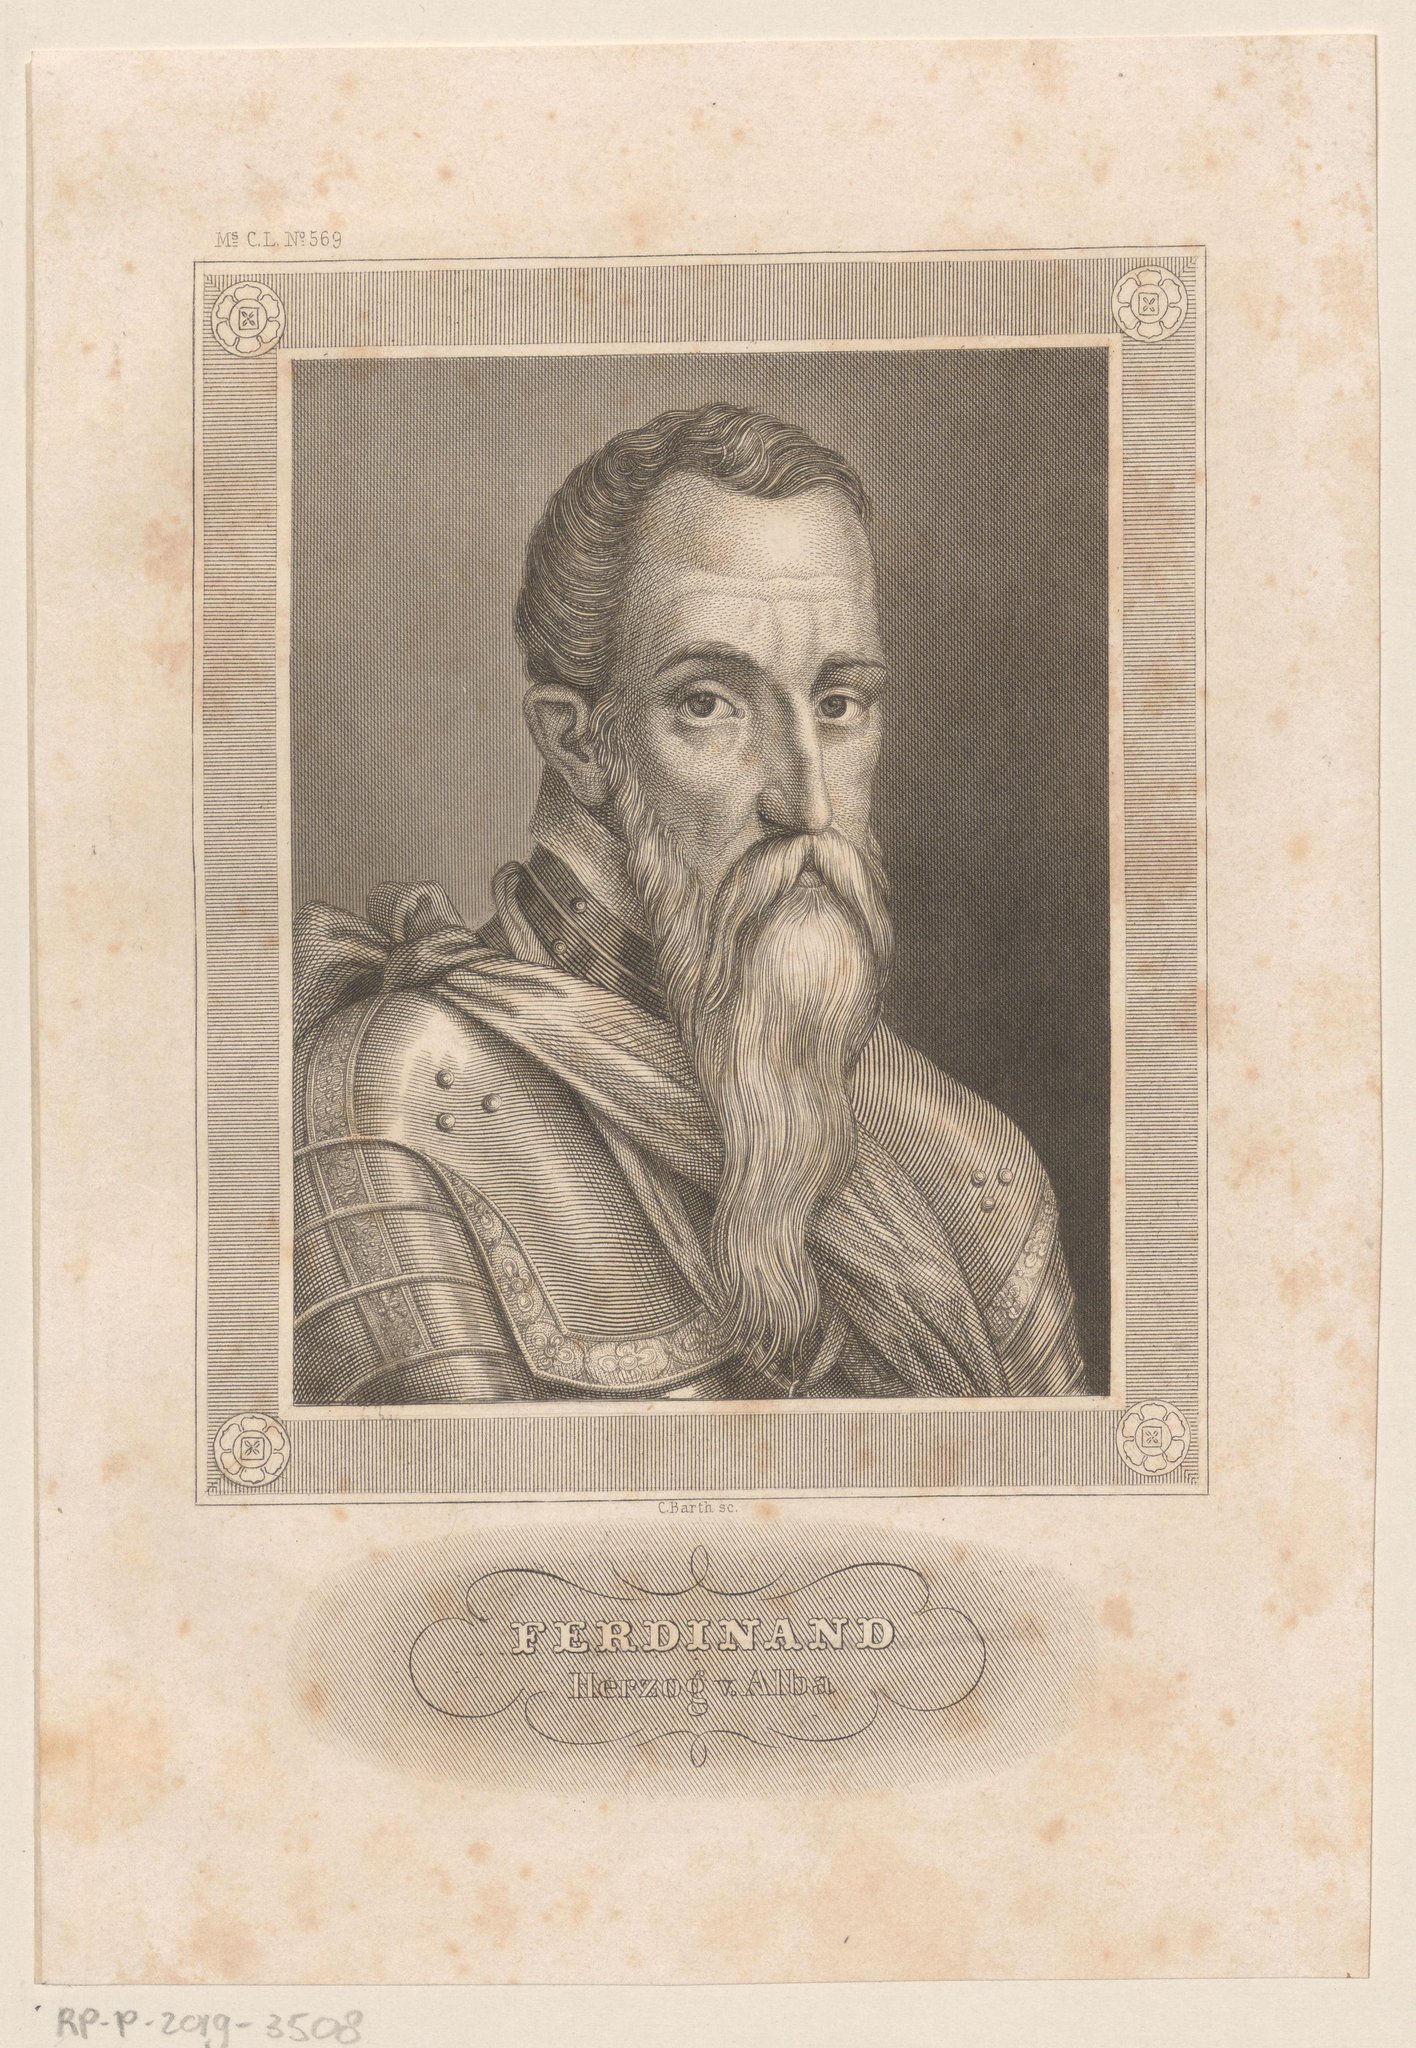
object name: print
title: Portret van Fernando Álvarez de Toledo, hertog van Alva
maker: karl barth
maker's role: print maker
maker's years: 1787-1853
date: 1828-1853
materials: paper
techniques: engraving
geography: hildburghausen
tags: fernando álvarez de toledo (3rd duke of alba), armour, historical persons